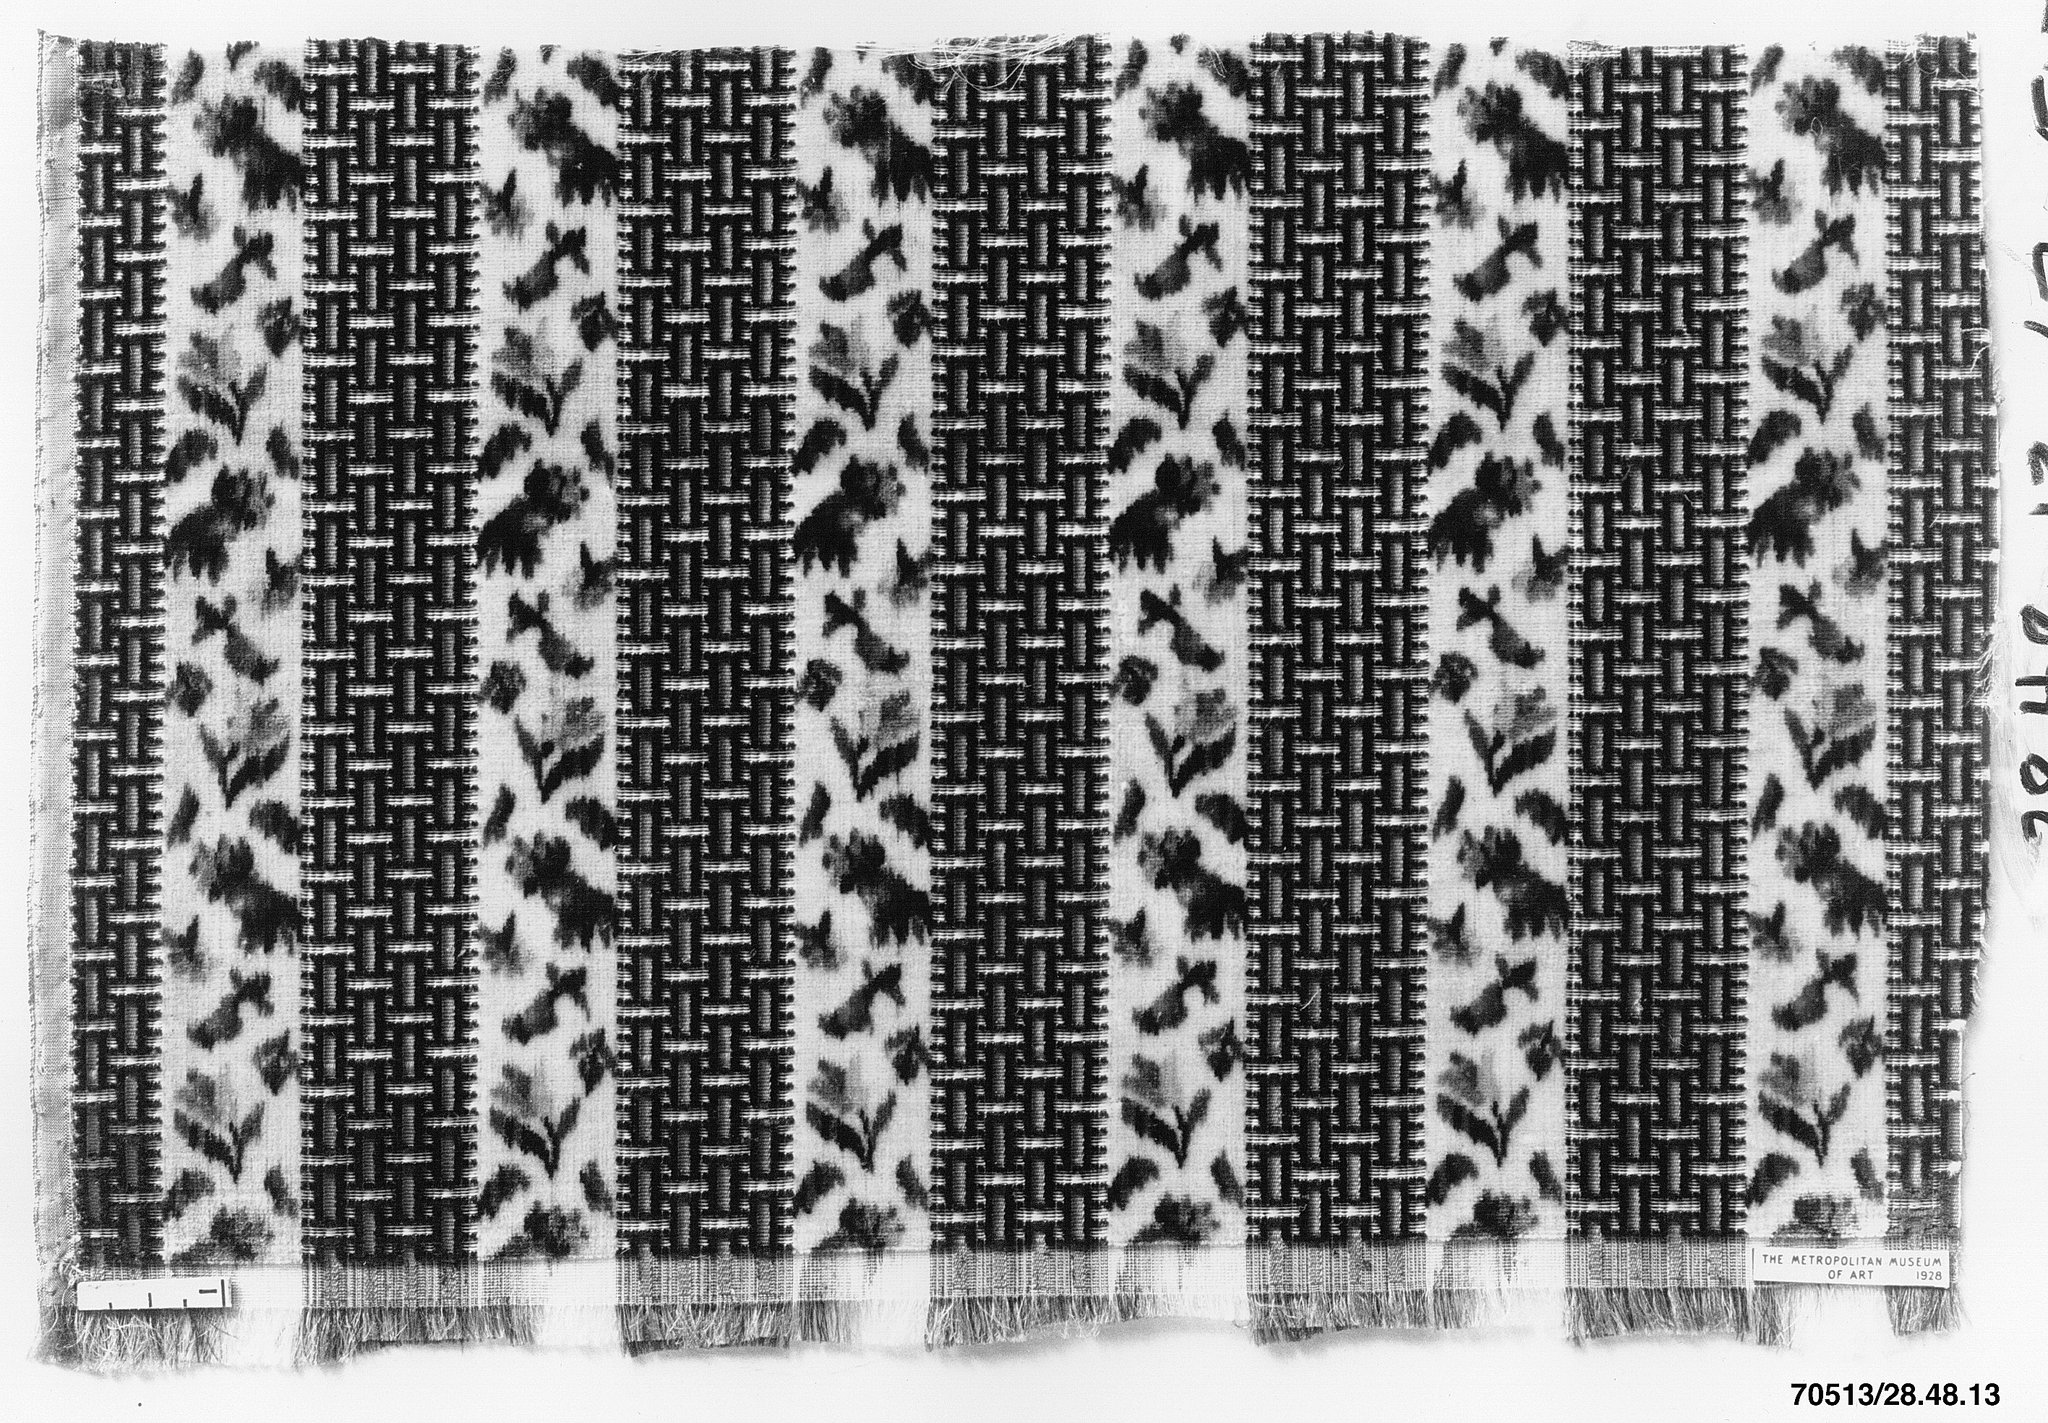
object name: piece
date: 1767-1833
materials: silk